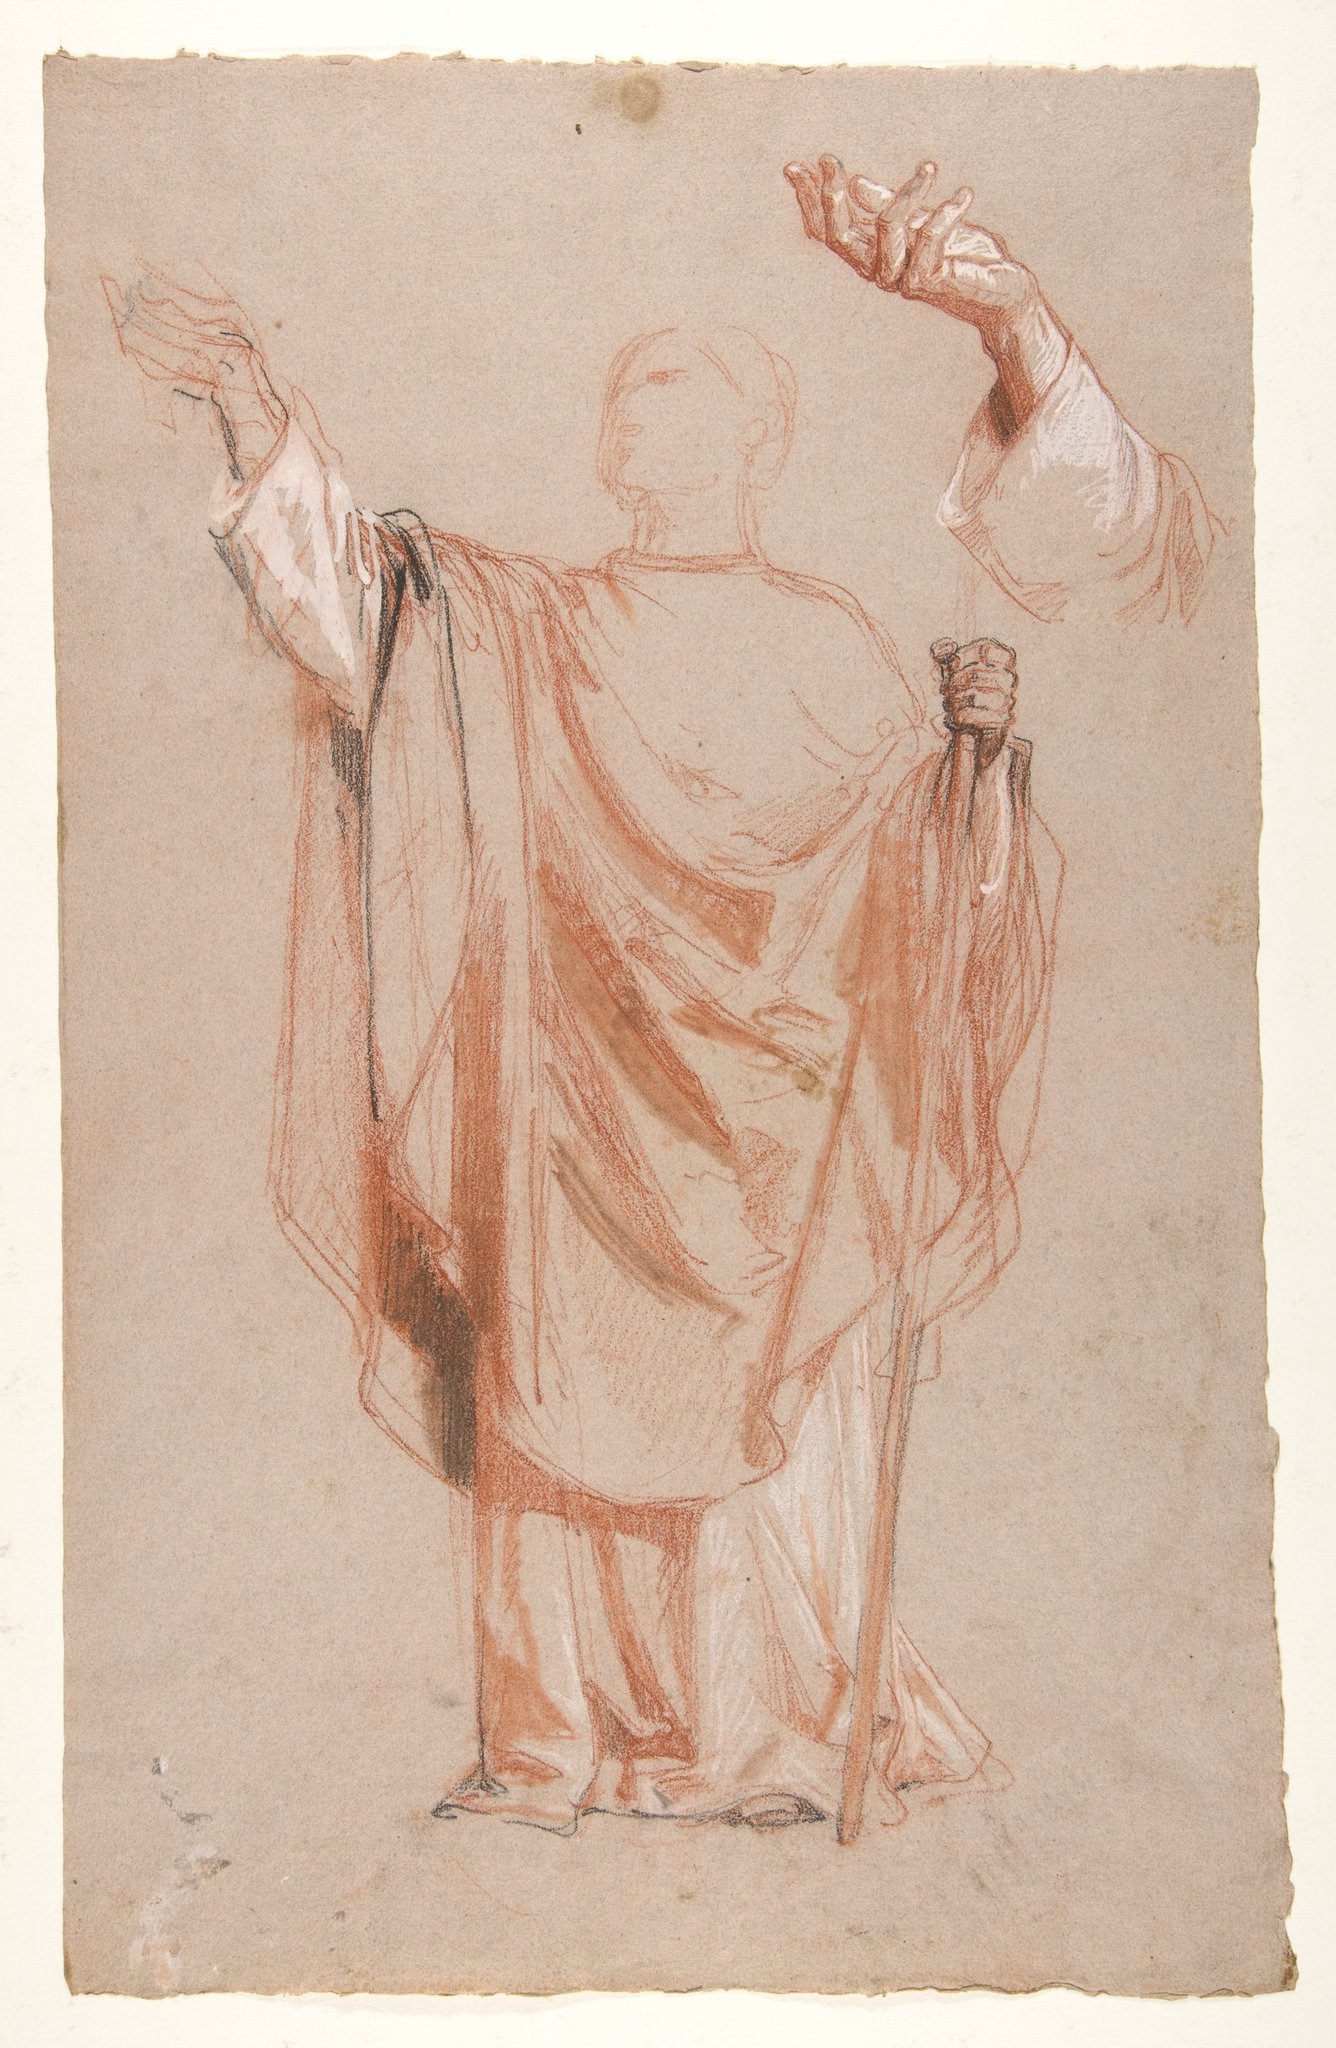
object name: drawing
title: Study for Saint Remi (middle register); verso: Study for Remi's Raised Arm (studies for wall paintings in the Chapel of Saint Remi, Sainte-Clotilde, Paris, 1858)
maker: isidore pils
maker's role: artist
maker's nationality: french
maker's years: 1813-1875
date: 1801-1900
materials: chalk, gouache, paper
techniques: heightening, stumping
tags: hands,saints